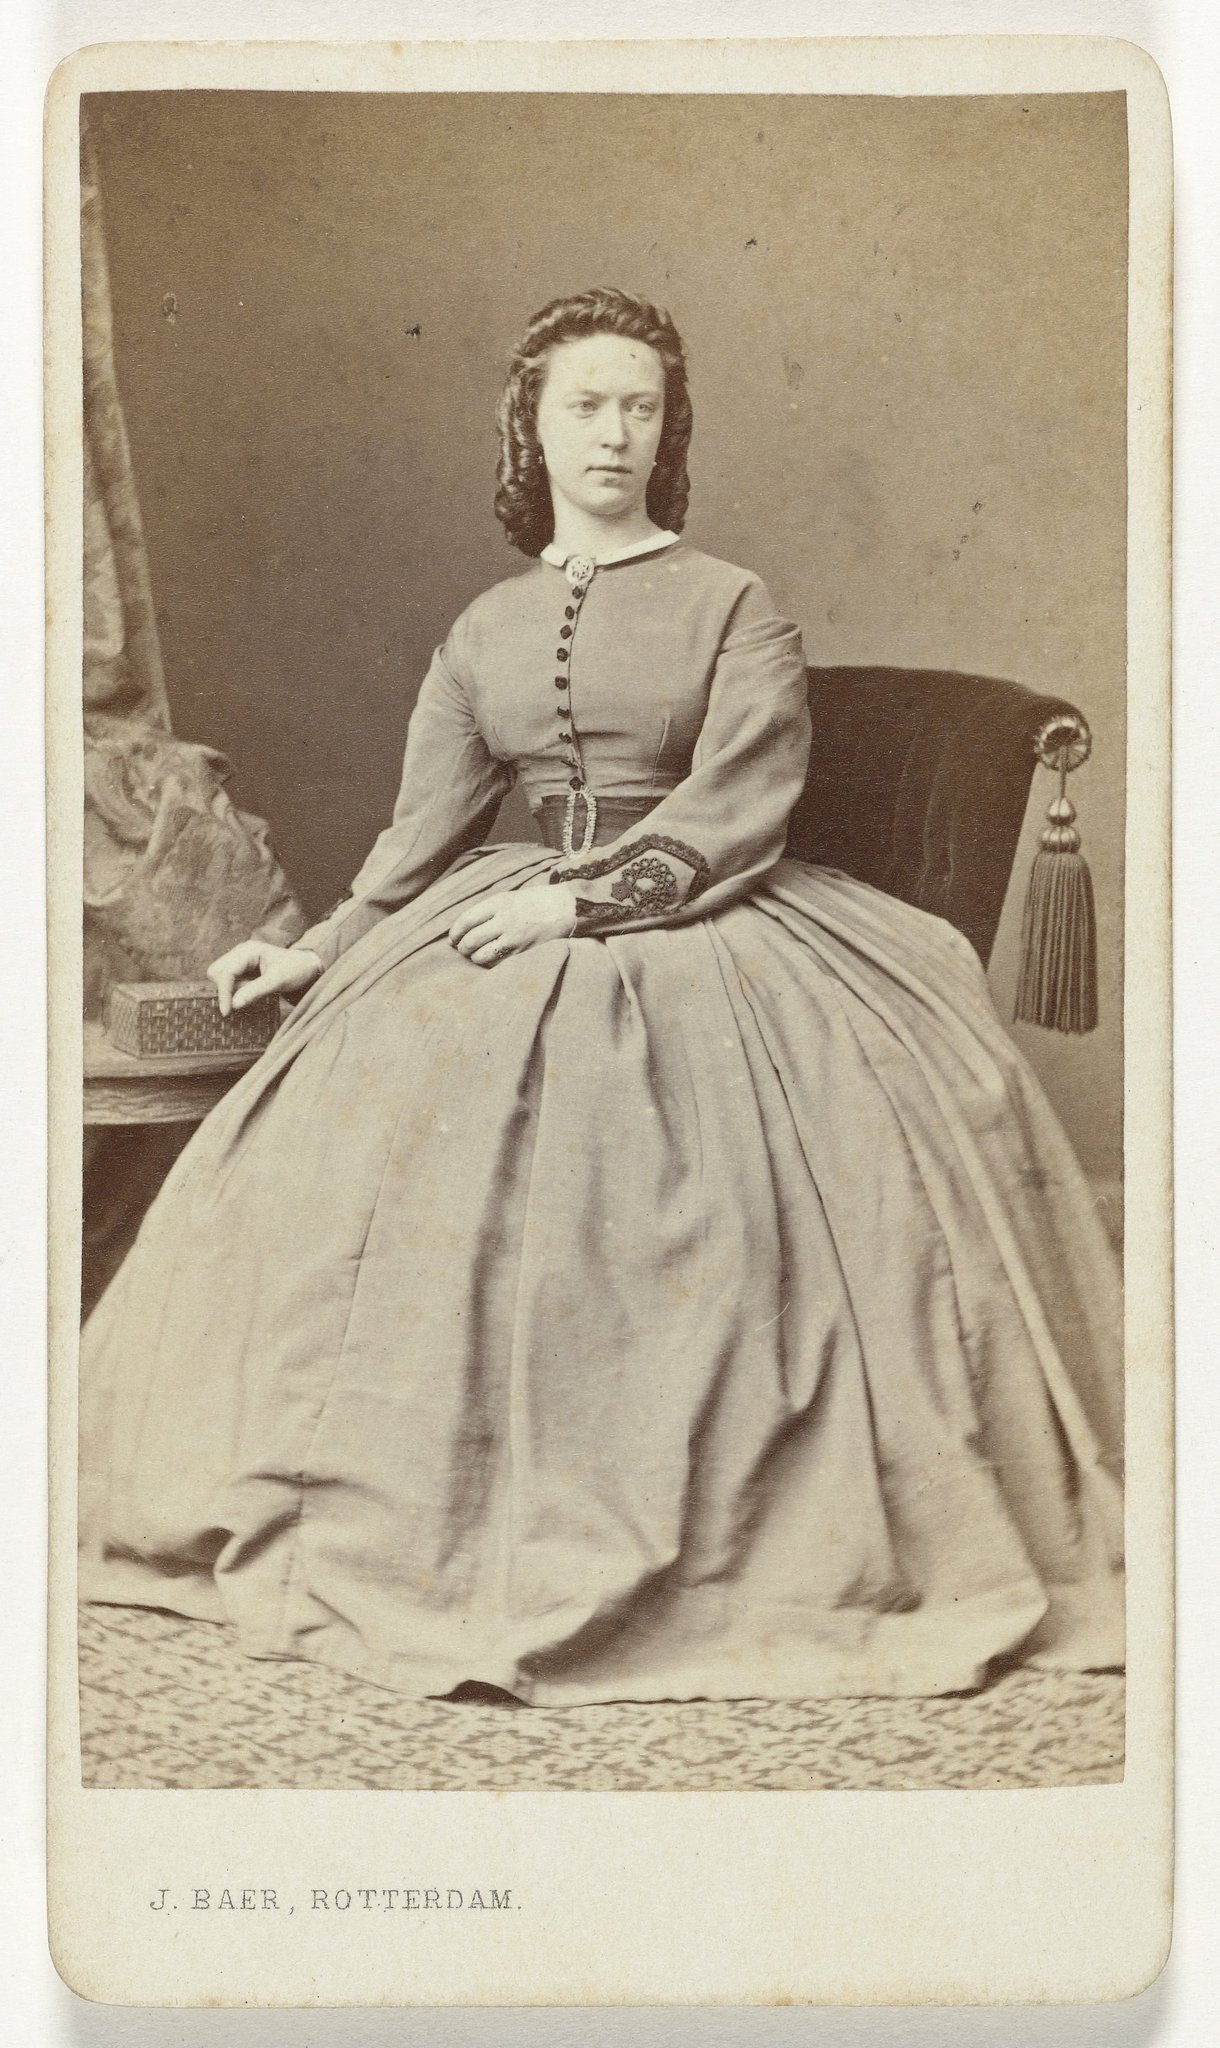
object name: photograph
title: Portret van een onbekende zittende vrouw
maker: johannes baer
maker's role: fotograaf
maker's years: 1840-1912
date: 1892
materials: cardboard, photographic support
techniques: albumen print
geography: rotterdam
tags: historical persons not known by name - bb - woman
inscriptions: address: ‘J. Baer/ PHOTOGRAPHE/ ROTTERDAM’, annotation: ‘F’, annotation: ‘nicht Saar/ van Oosten?/ te R'dam.’